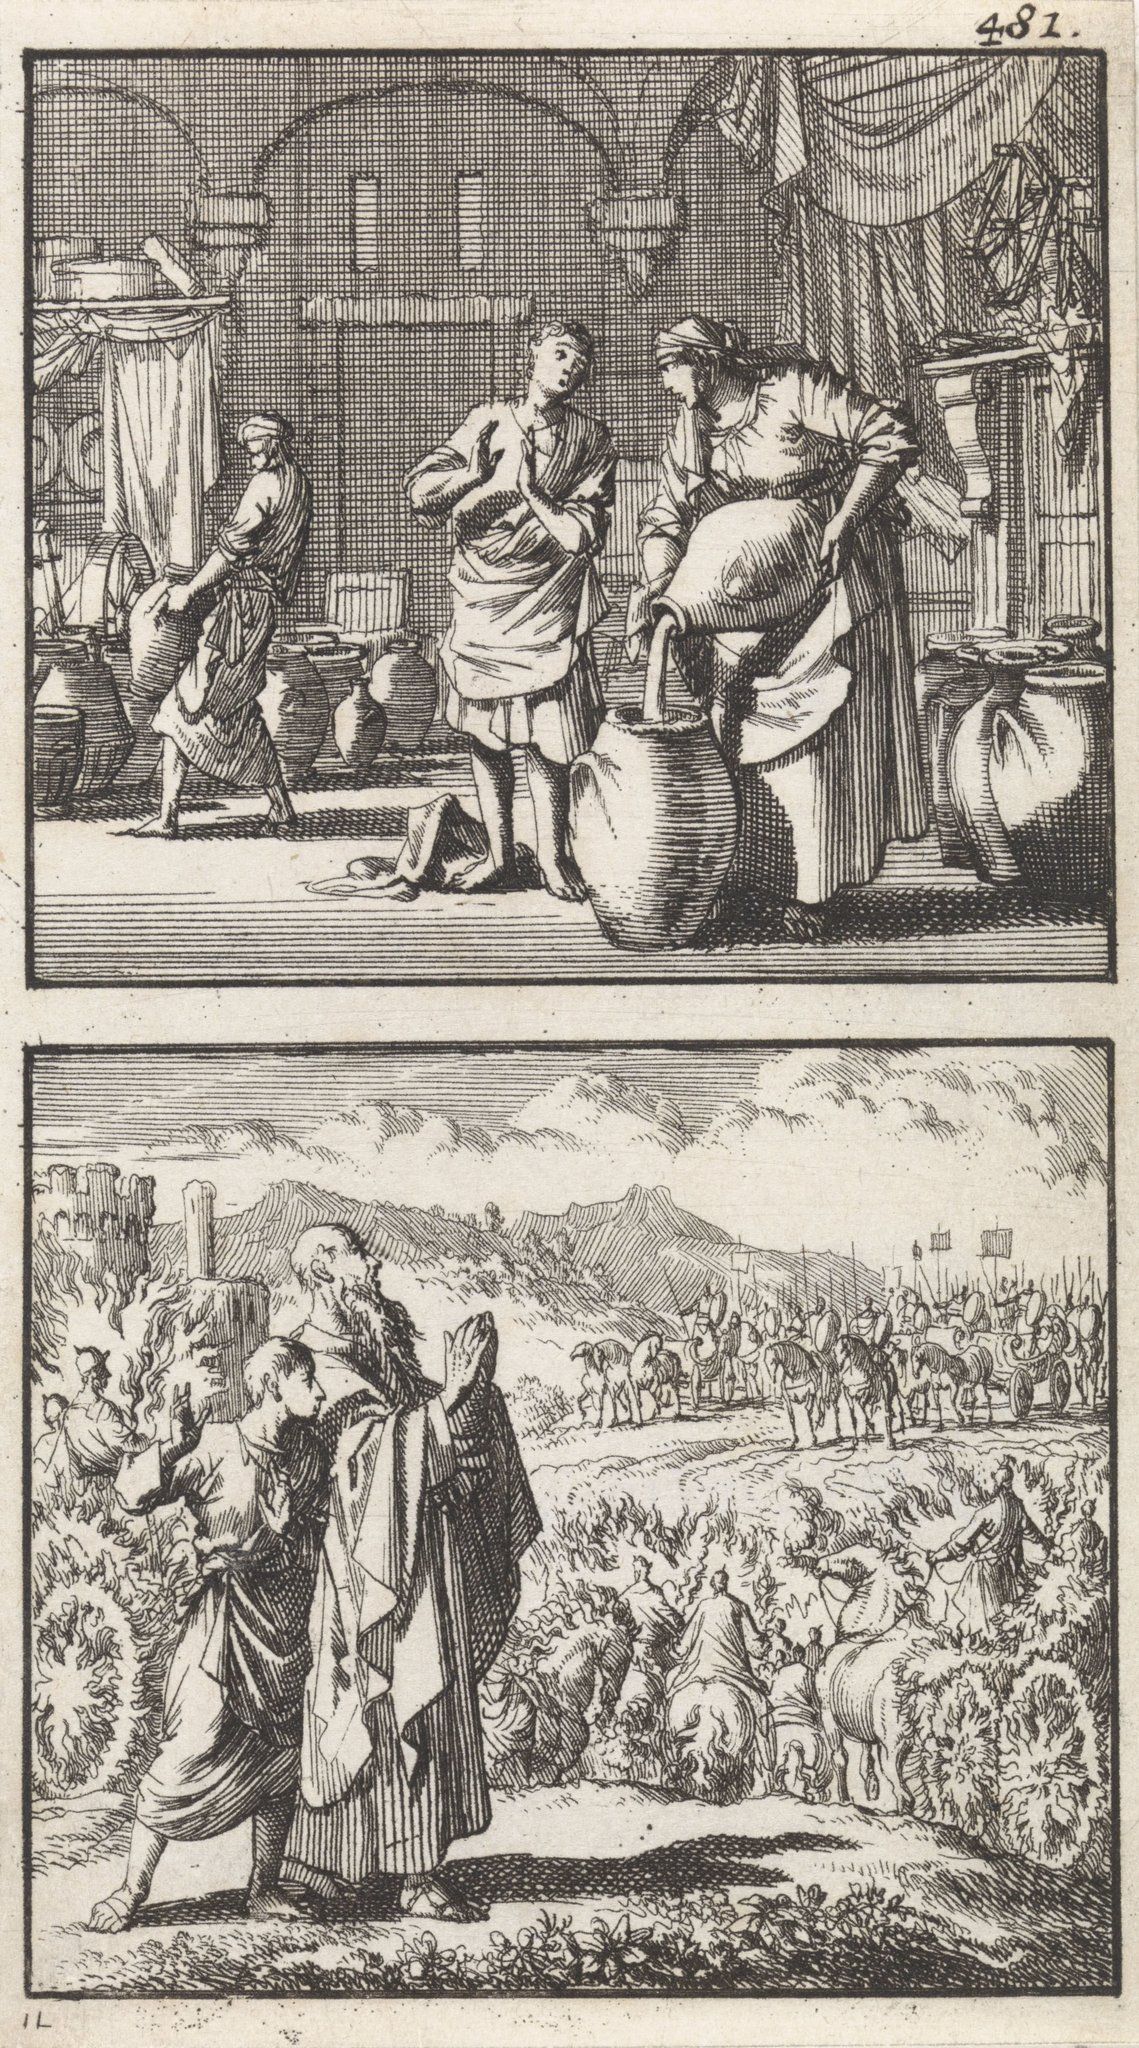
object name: book illustration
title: De weduwe van Sarefat vult de wonderbaarlijke kruik met olie / Elisa’s optreden in de oorlog tegen Aram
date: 1698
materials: paper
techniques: etching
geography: amsterdam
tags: the widow's oil: the little oil a woman has in store increases so that she and her son are able to fill many borrowed jars with it (2 kings 4:1-7), story of elisha (eliseus)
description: Illustratie uit: Josephus, Flavius. XX. boeken van de oude geschiedenissen der joden, 4 delen. Amsterdam: Barent Visscher, Willem de Coup, Willem van Lamsveld, Andries van Damme, 1698, dl. I.